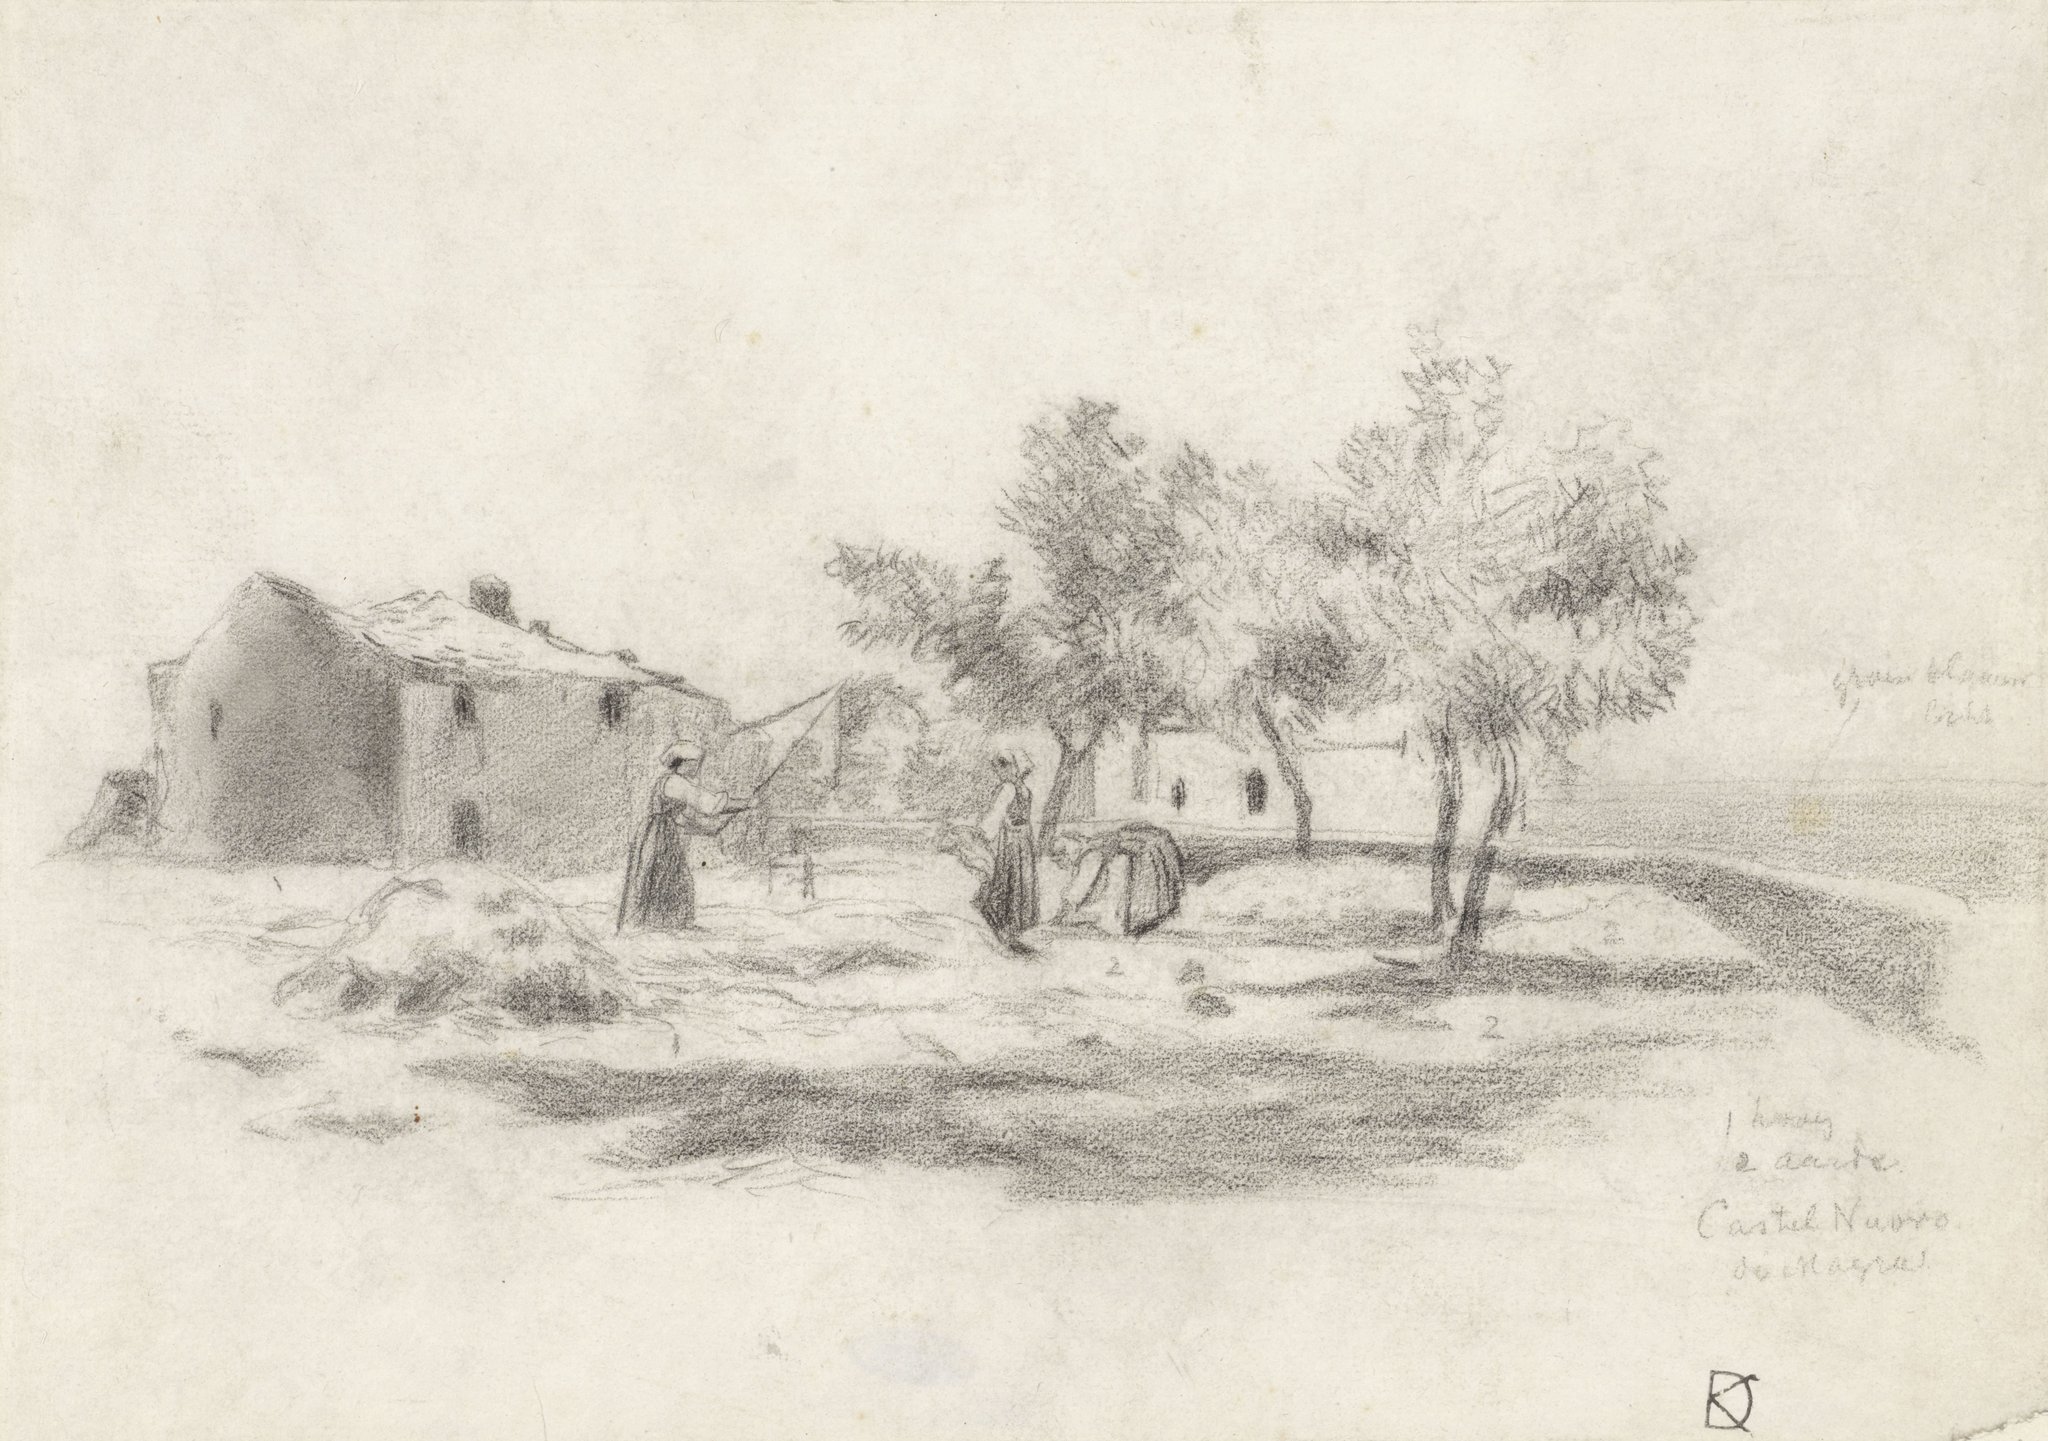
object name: drawing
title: Dorsende vrouwen voor een boerderij in Castelnuovo di Magra te Italië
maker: johan daniël koelman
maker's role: draughtsman, print maker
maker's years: 1831-1857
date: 1841-1857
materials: chalk, paper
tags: threshing, farm or solitary house in landscape